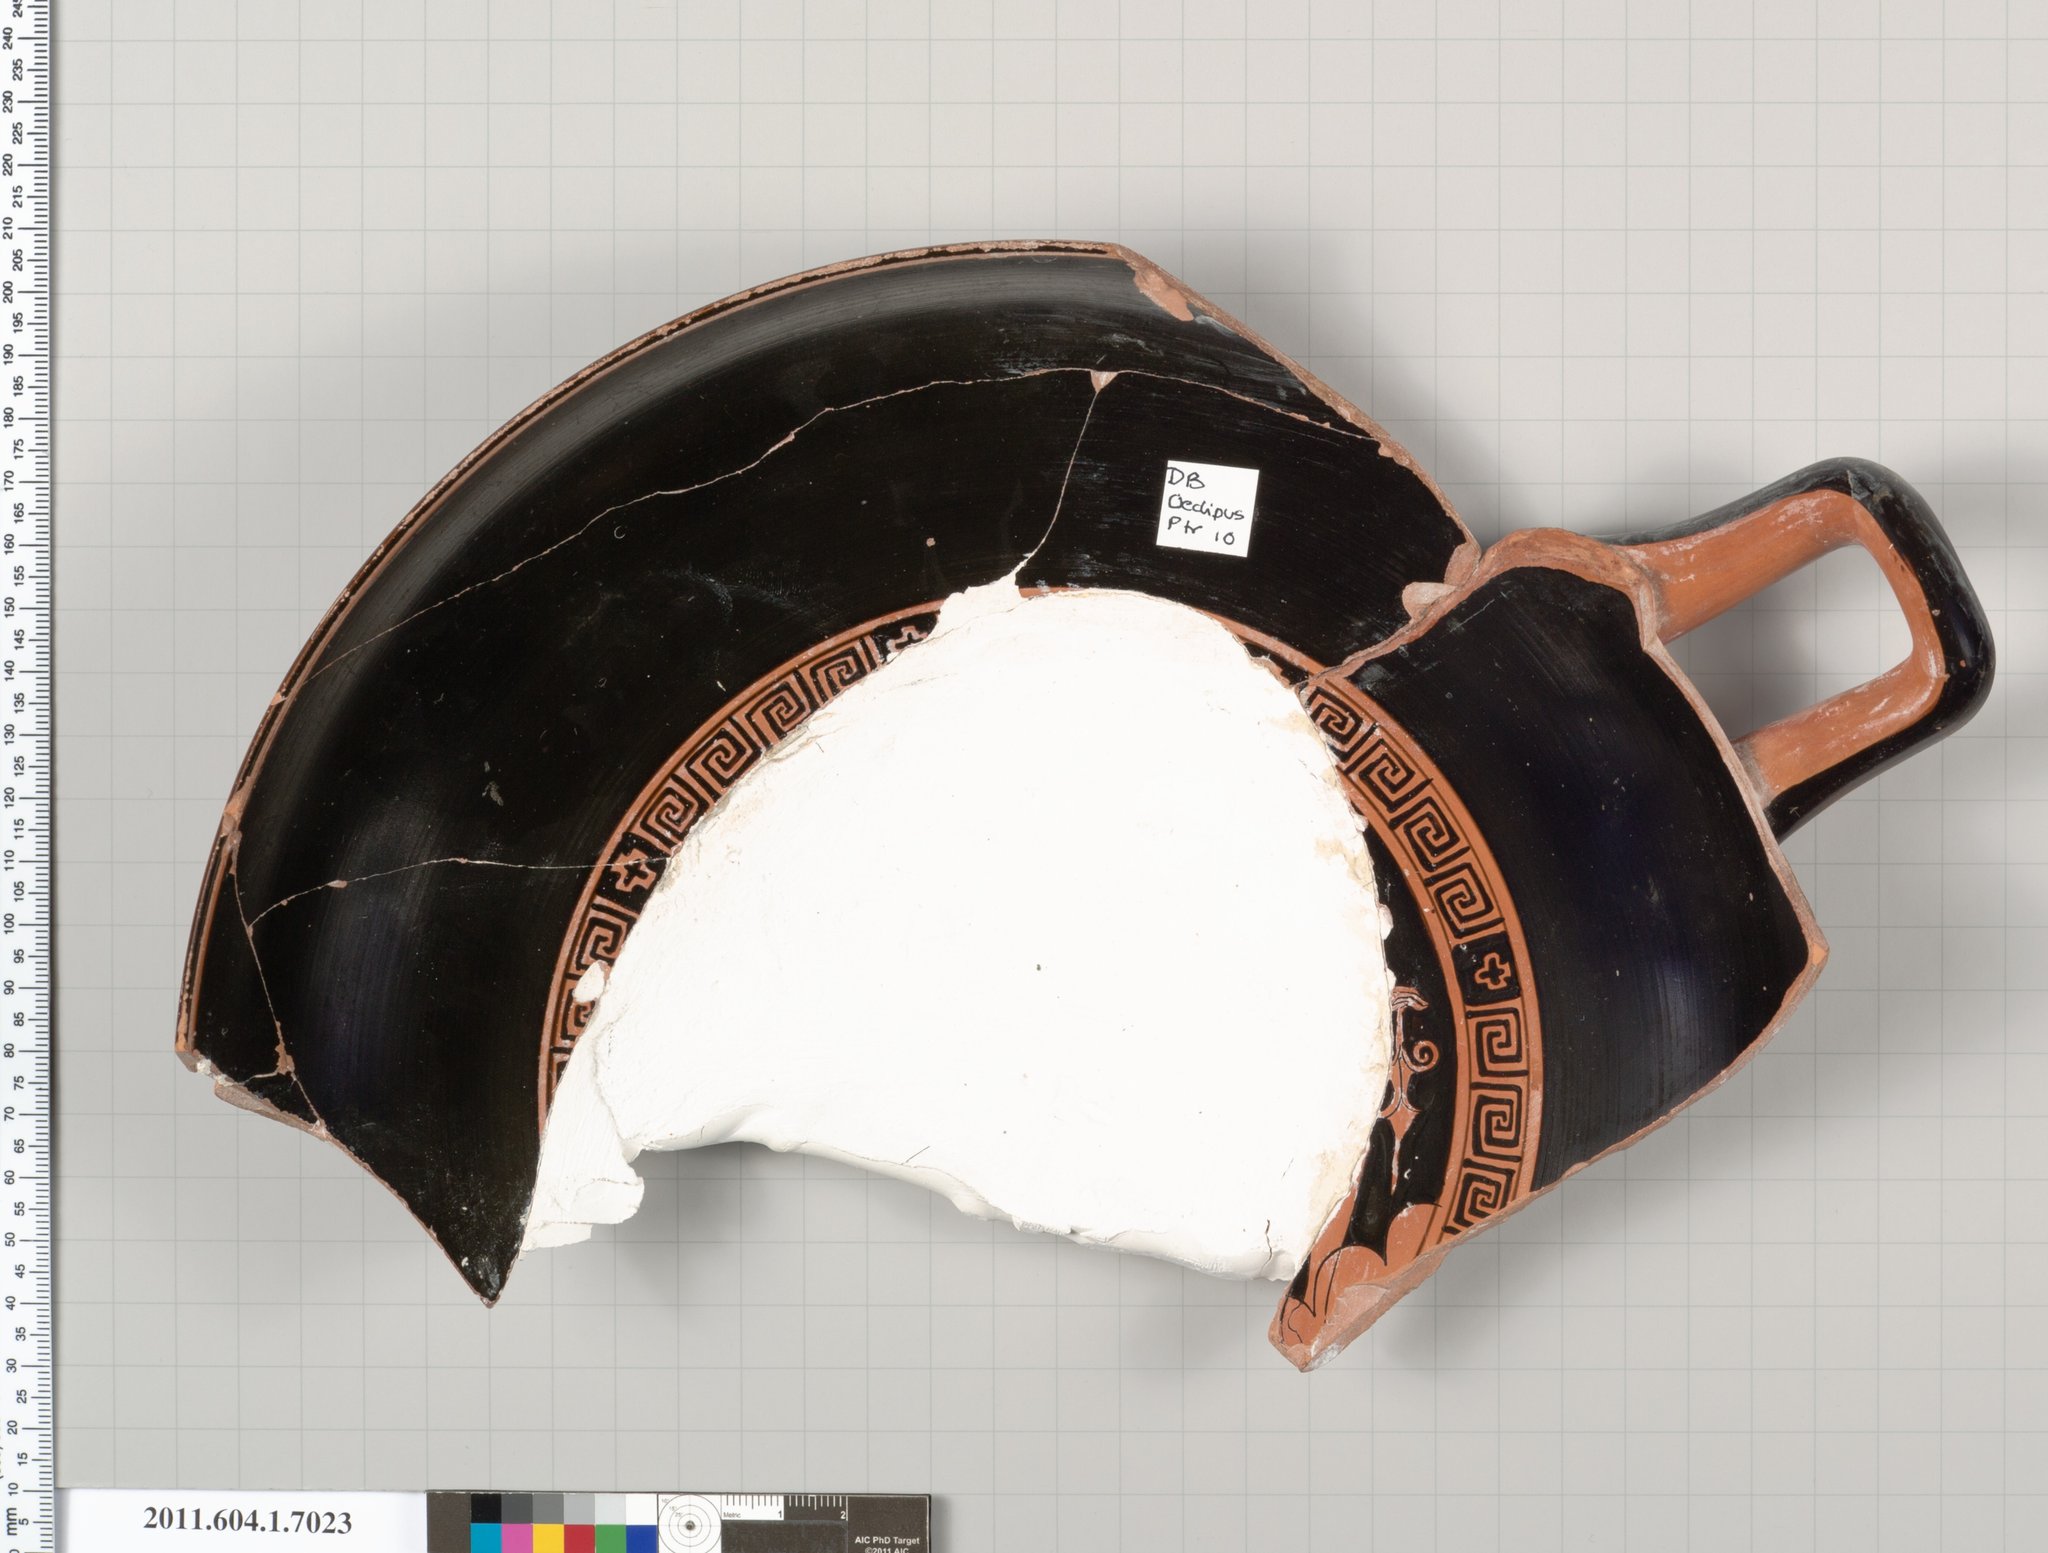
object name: kylix fragment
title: Terracotta fragment of a kylix (drinking cup)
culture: greek, attic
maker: oedipus painter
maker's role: artist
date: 500-480 BCE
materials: terracotta